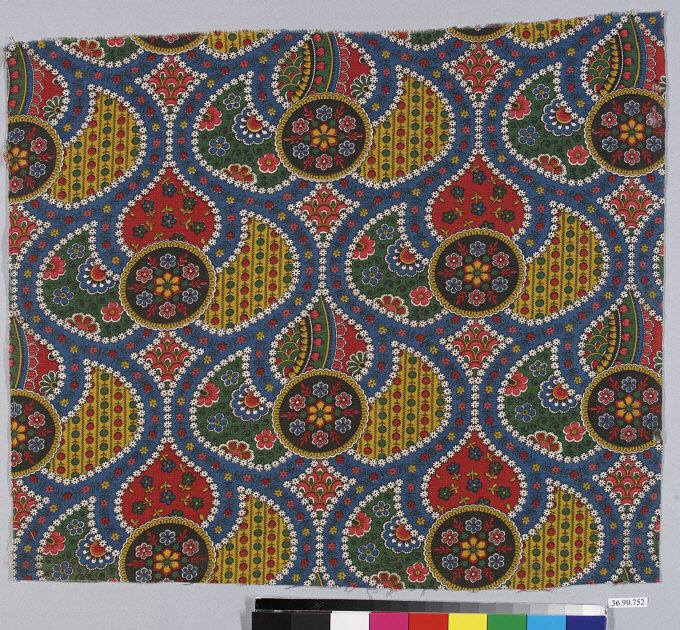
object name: piece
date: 1867-1900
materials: cotton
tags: flowers